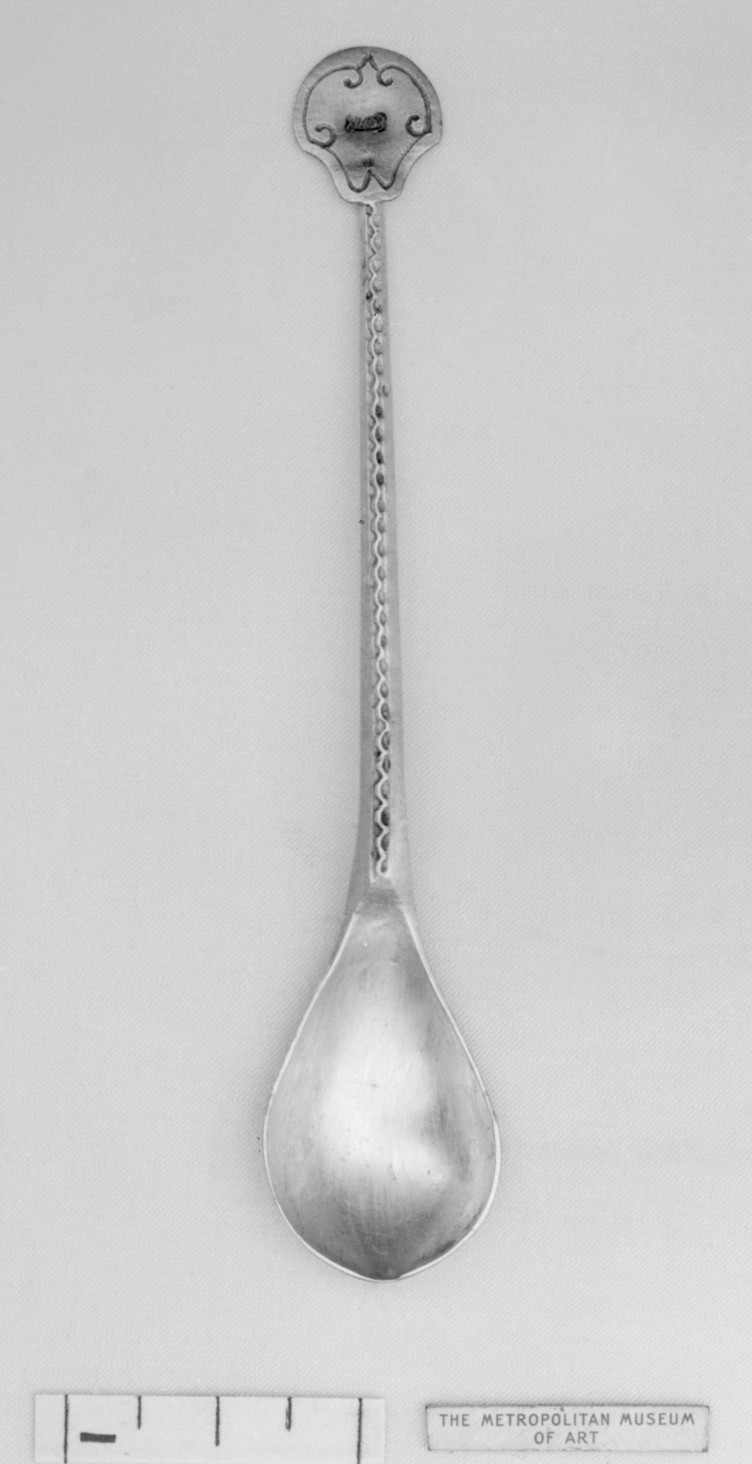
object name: mustard spoon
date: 1751-1800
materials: silver